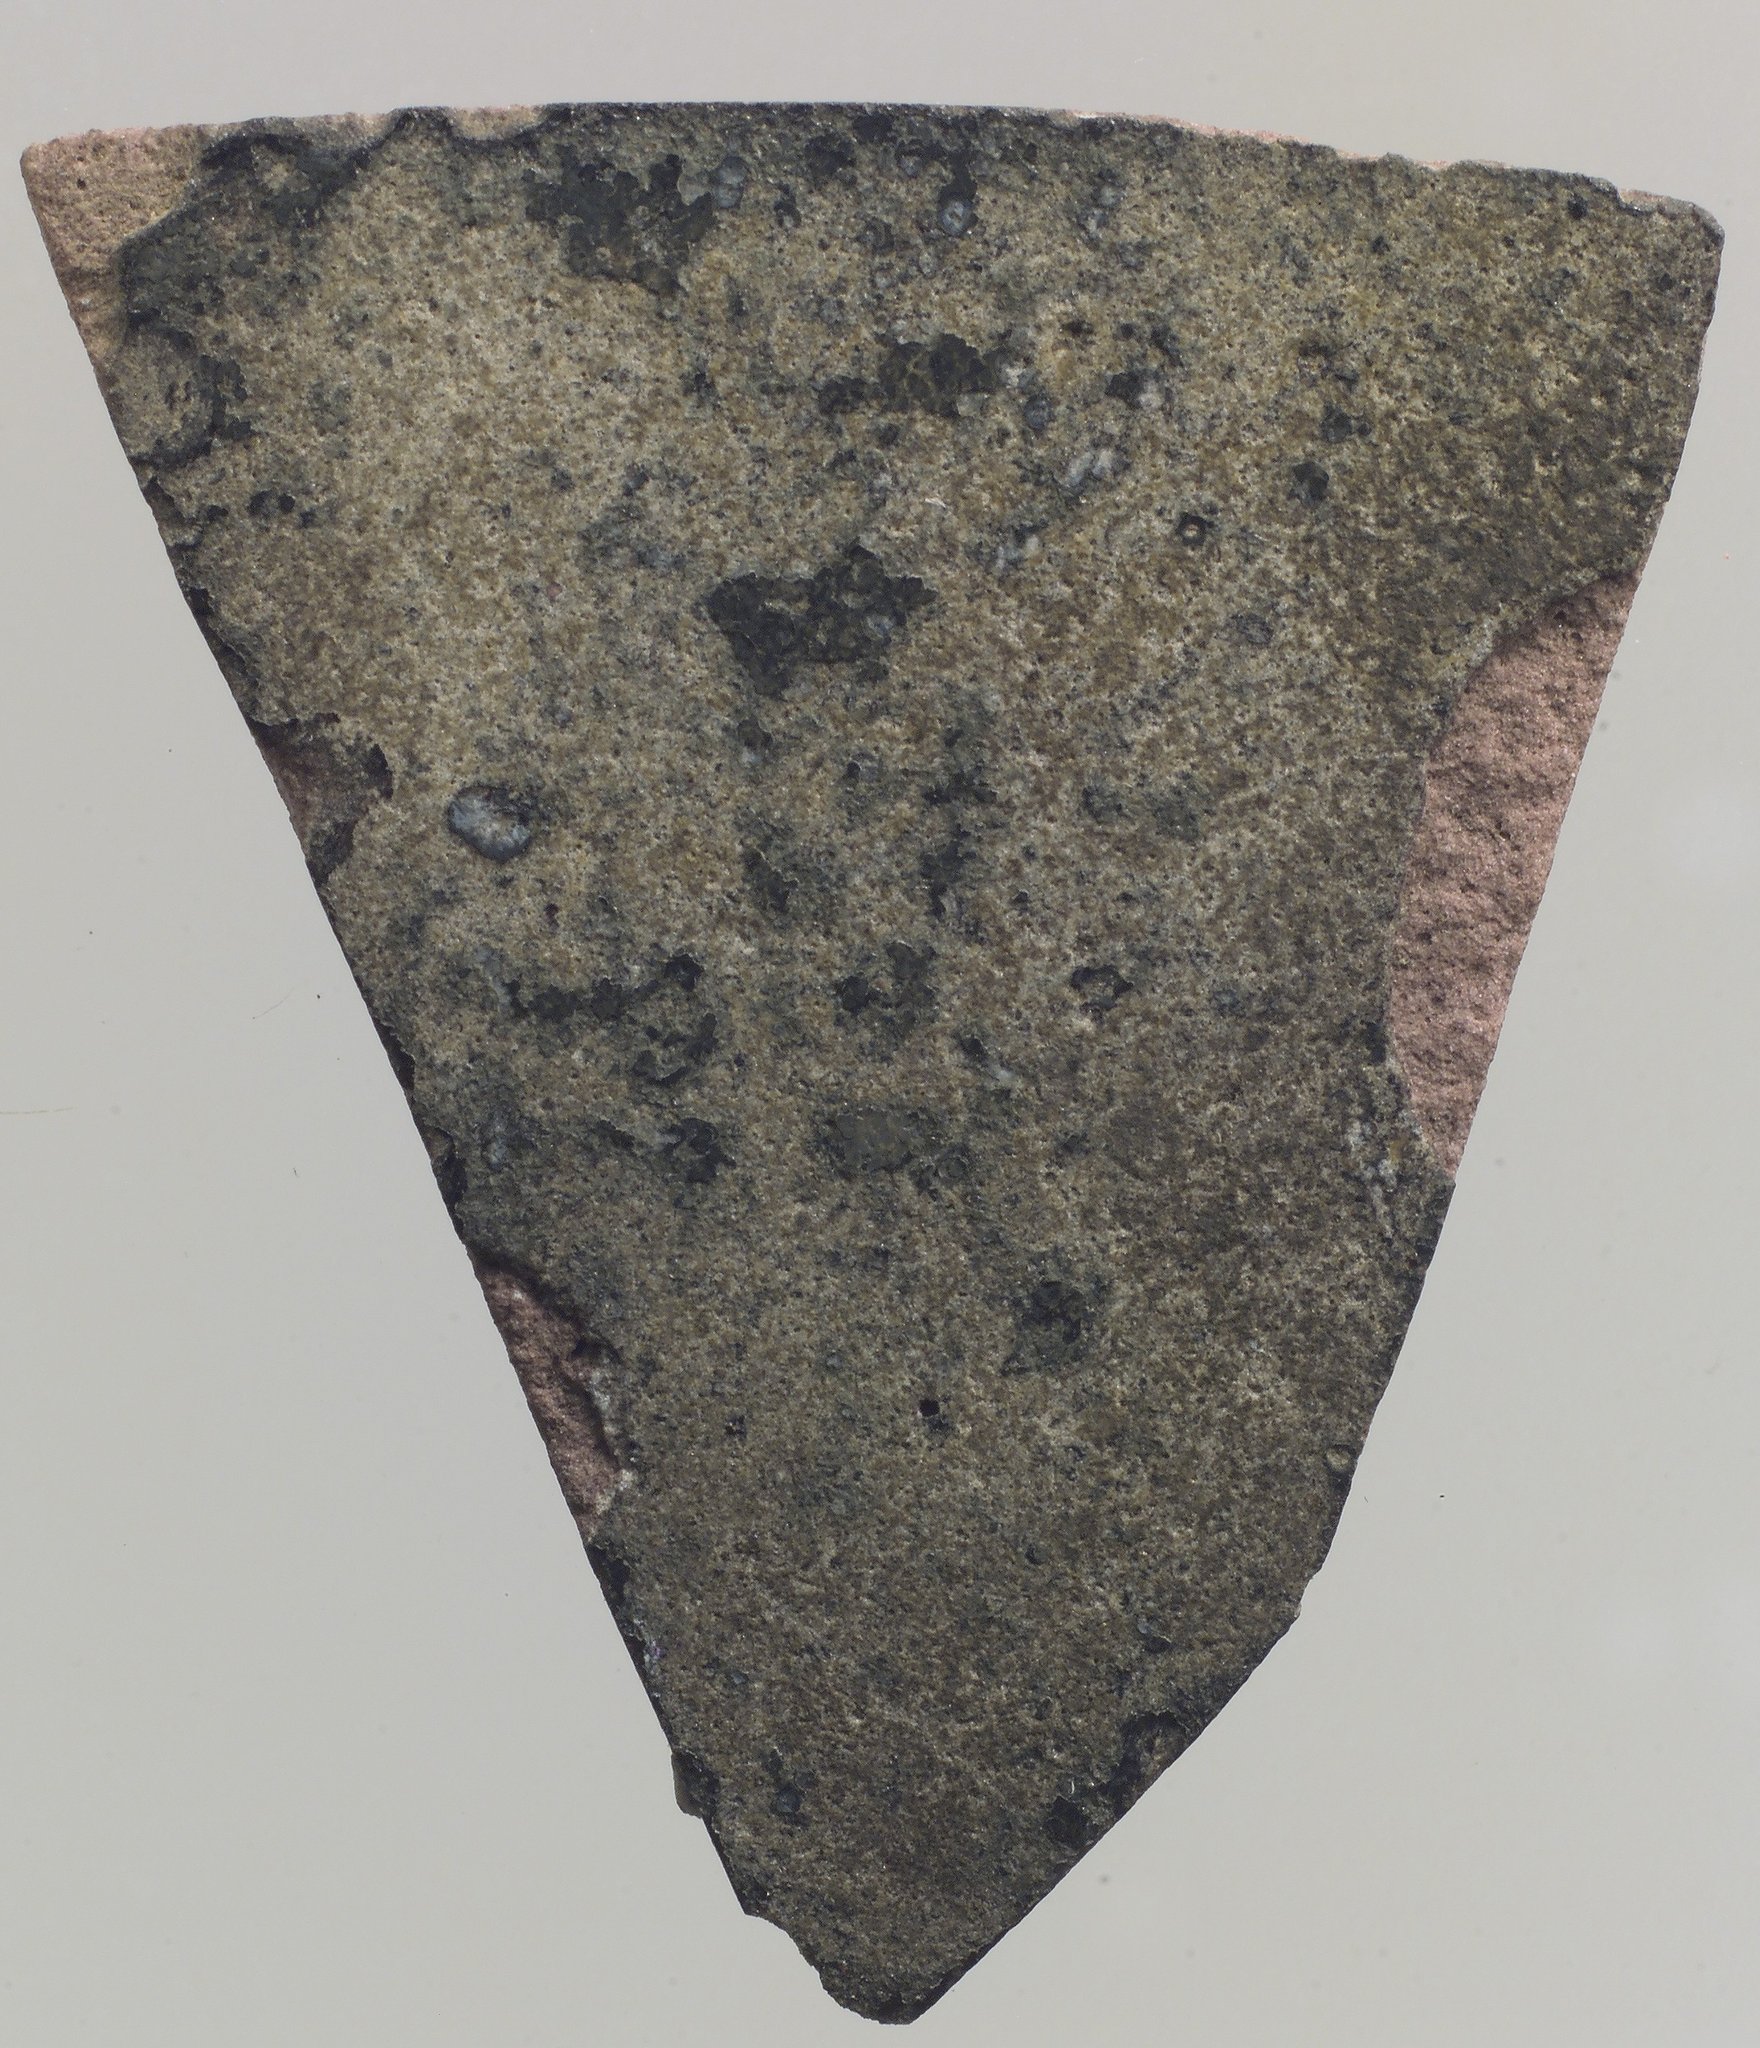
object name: furniture element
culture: assyrian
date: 1800-1701 BCE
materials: ivory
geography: anatolia